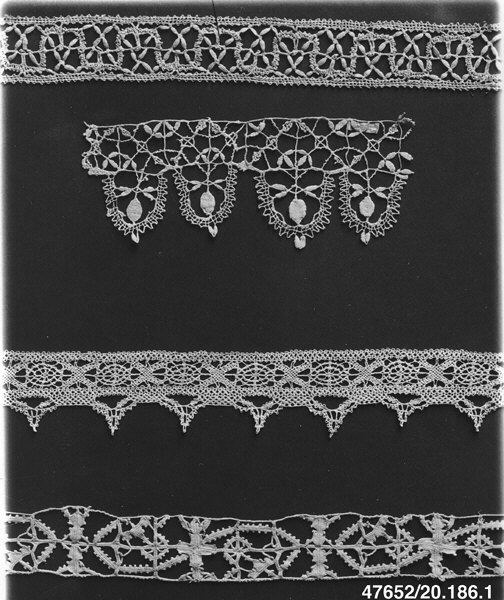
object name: insertion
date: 1501-1600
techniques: lace